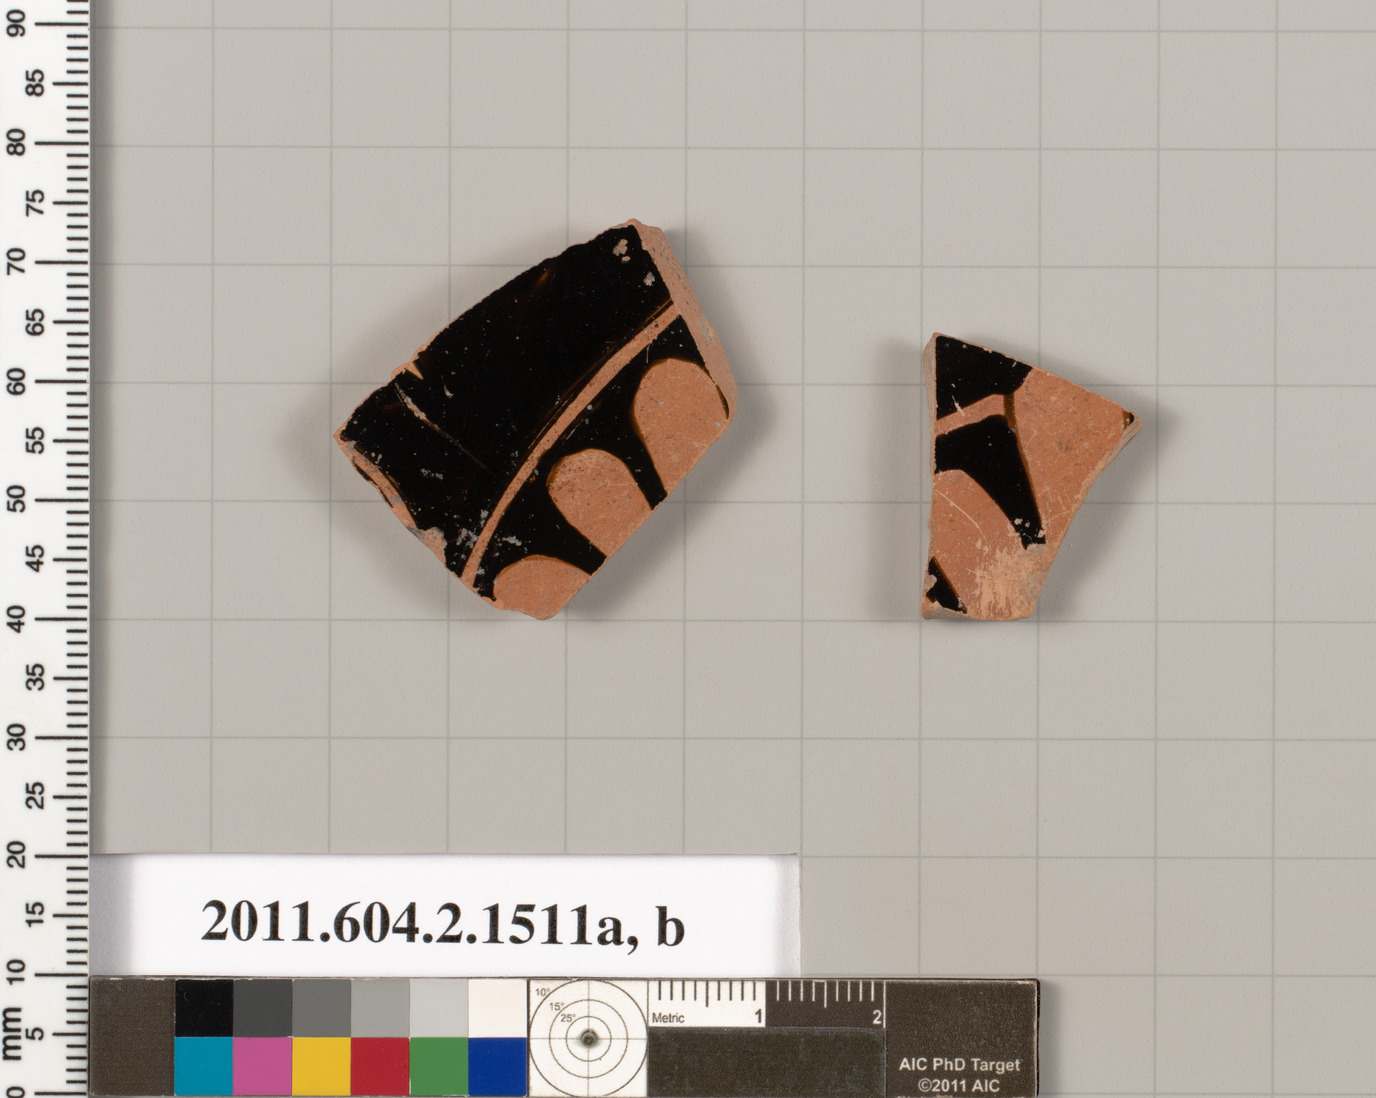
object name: skyphos fragment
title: Terracotta fragments of skyphoi (deep drinking cups)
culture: greek, attic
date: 475-451 BCE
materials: terracotta